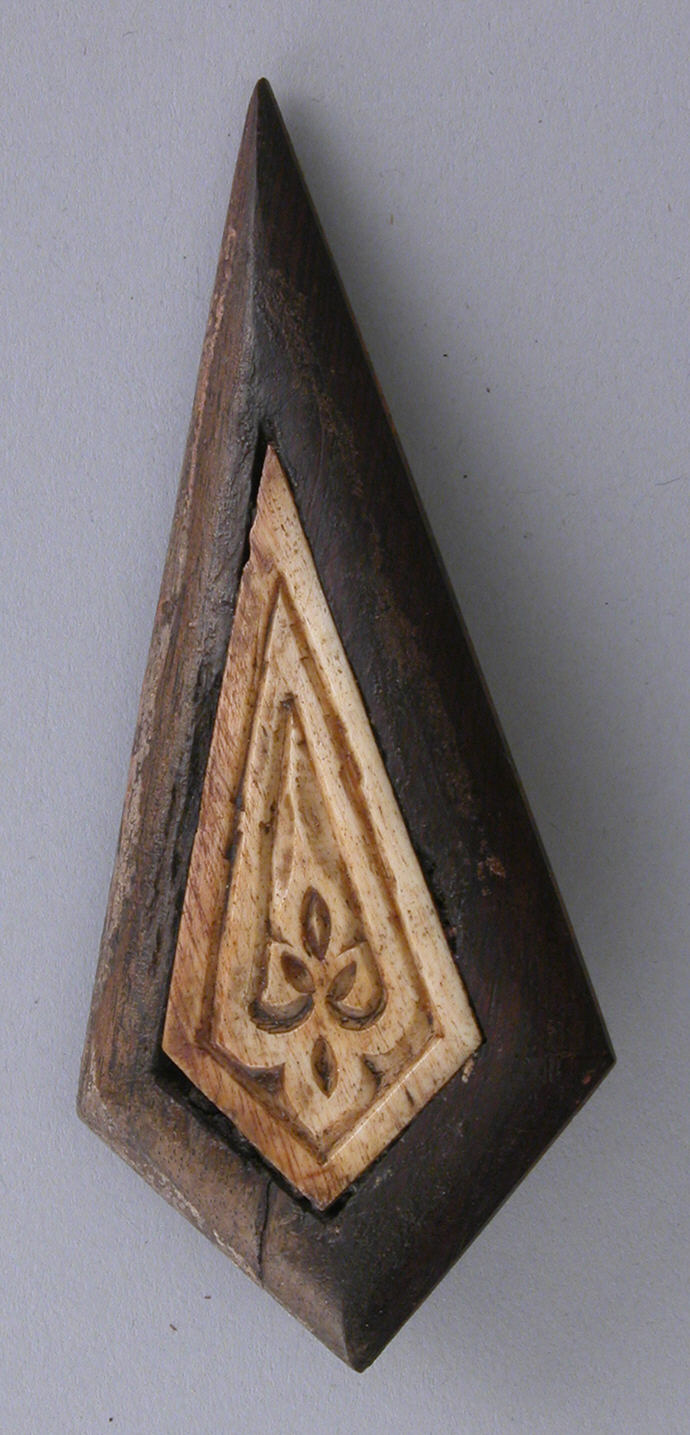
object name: panel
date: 1301-1500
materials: ivory, wood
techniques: carving, inlay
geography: egypt